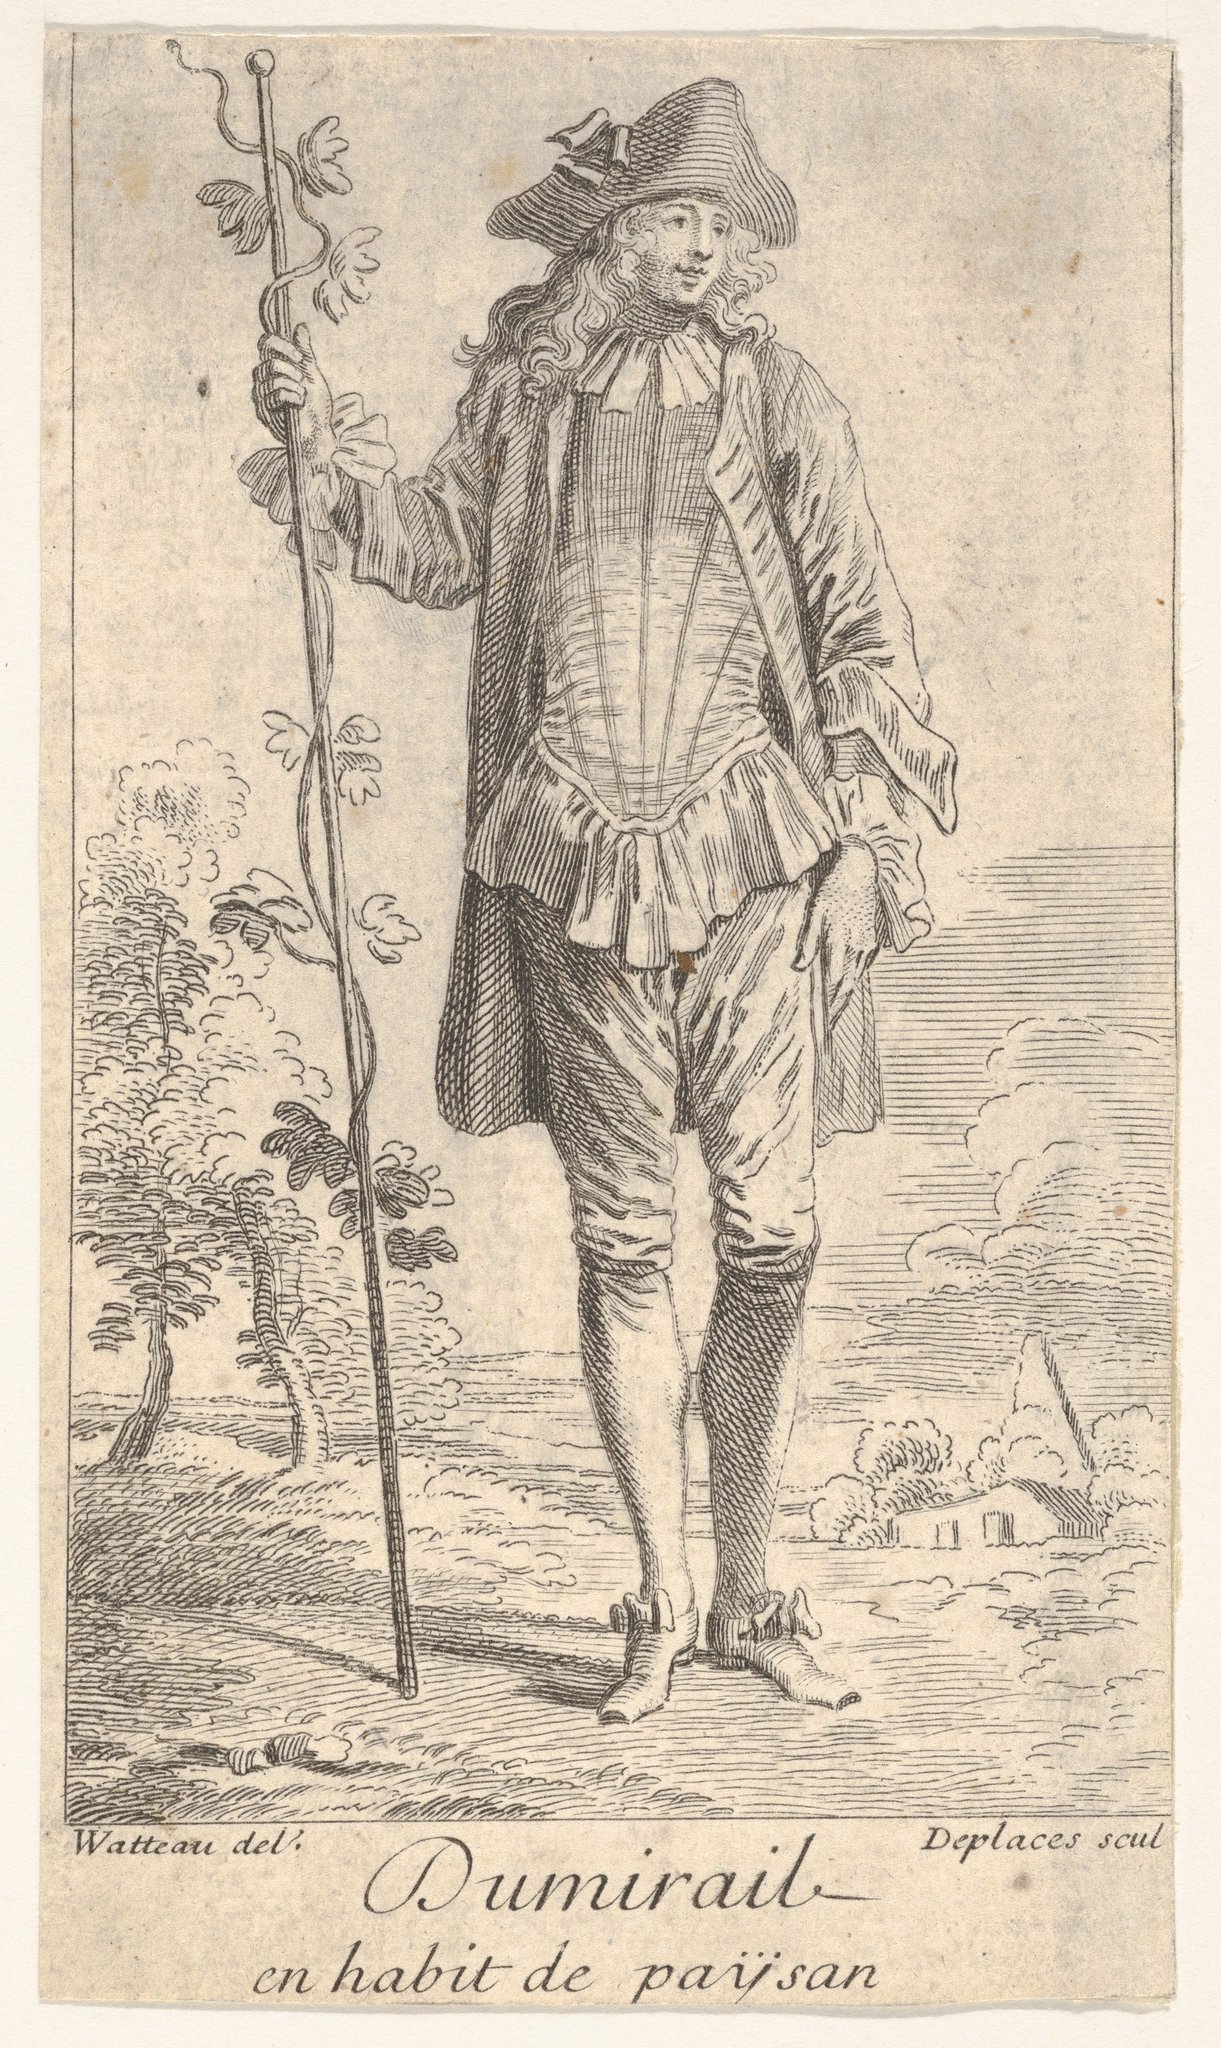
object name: print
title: Man in tricorn hat and overcoat, shown in frontal view and holding a staff with a winding vine, landscape with trees beyond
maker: louis desplaces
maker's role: artist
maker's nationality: french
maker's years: 1682-1739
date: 1710-1739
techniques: engraving, etching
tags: men